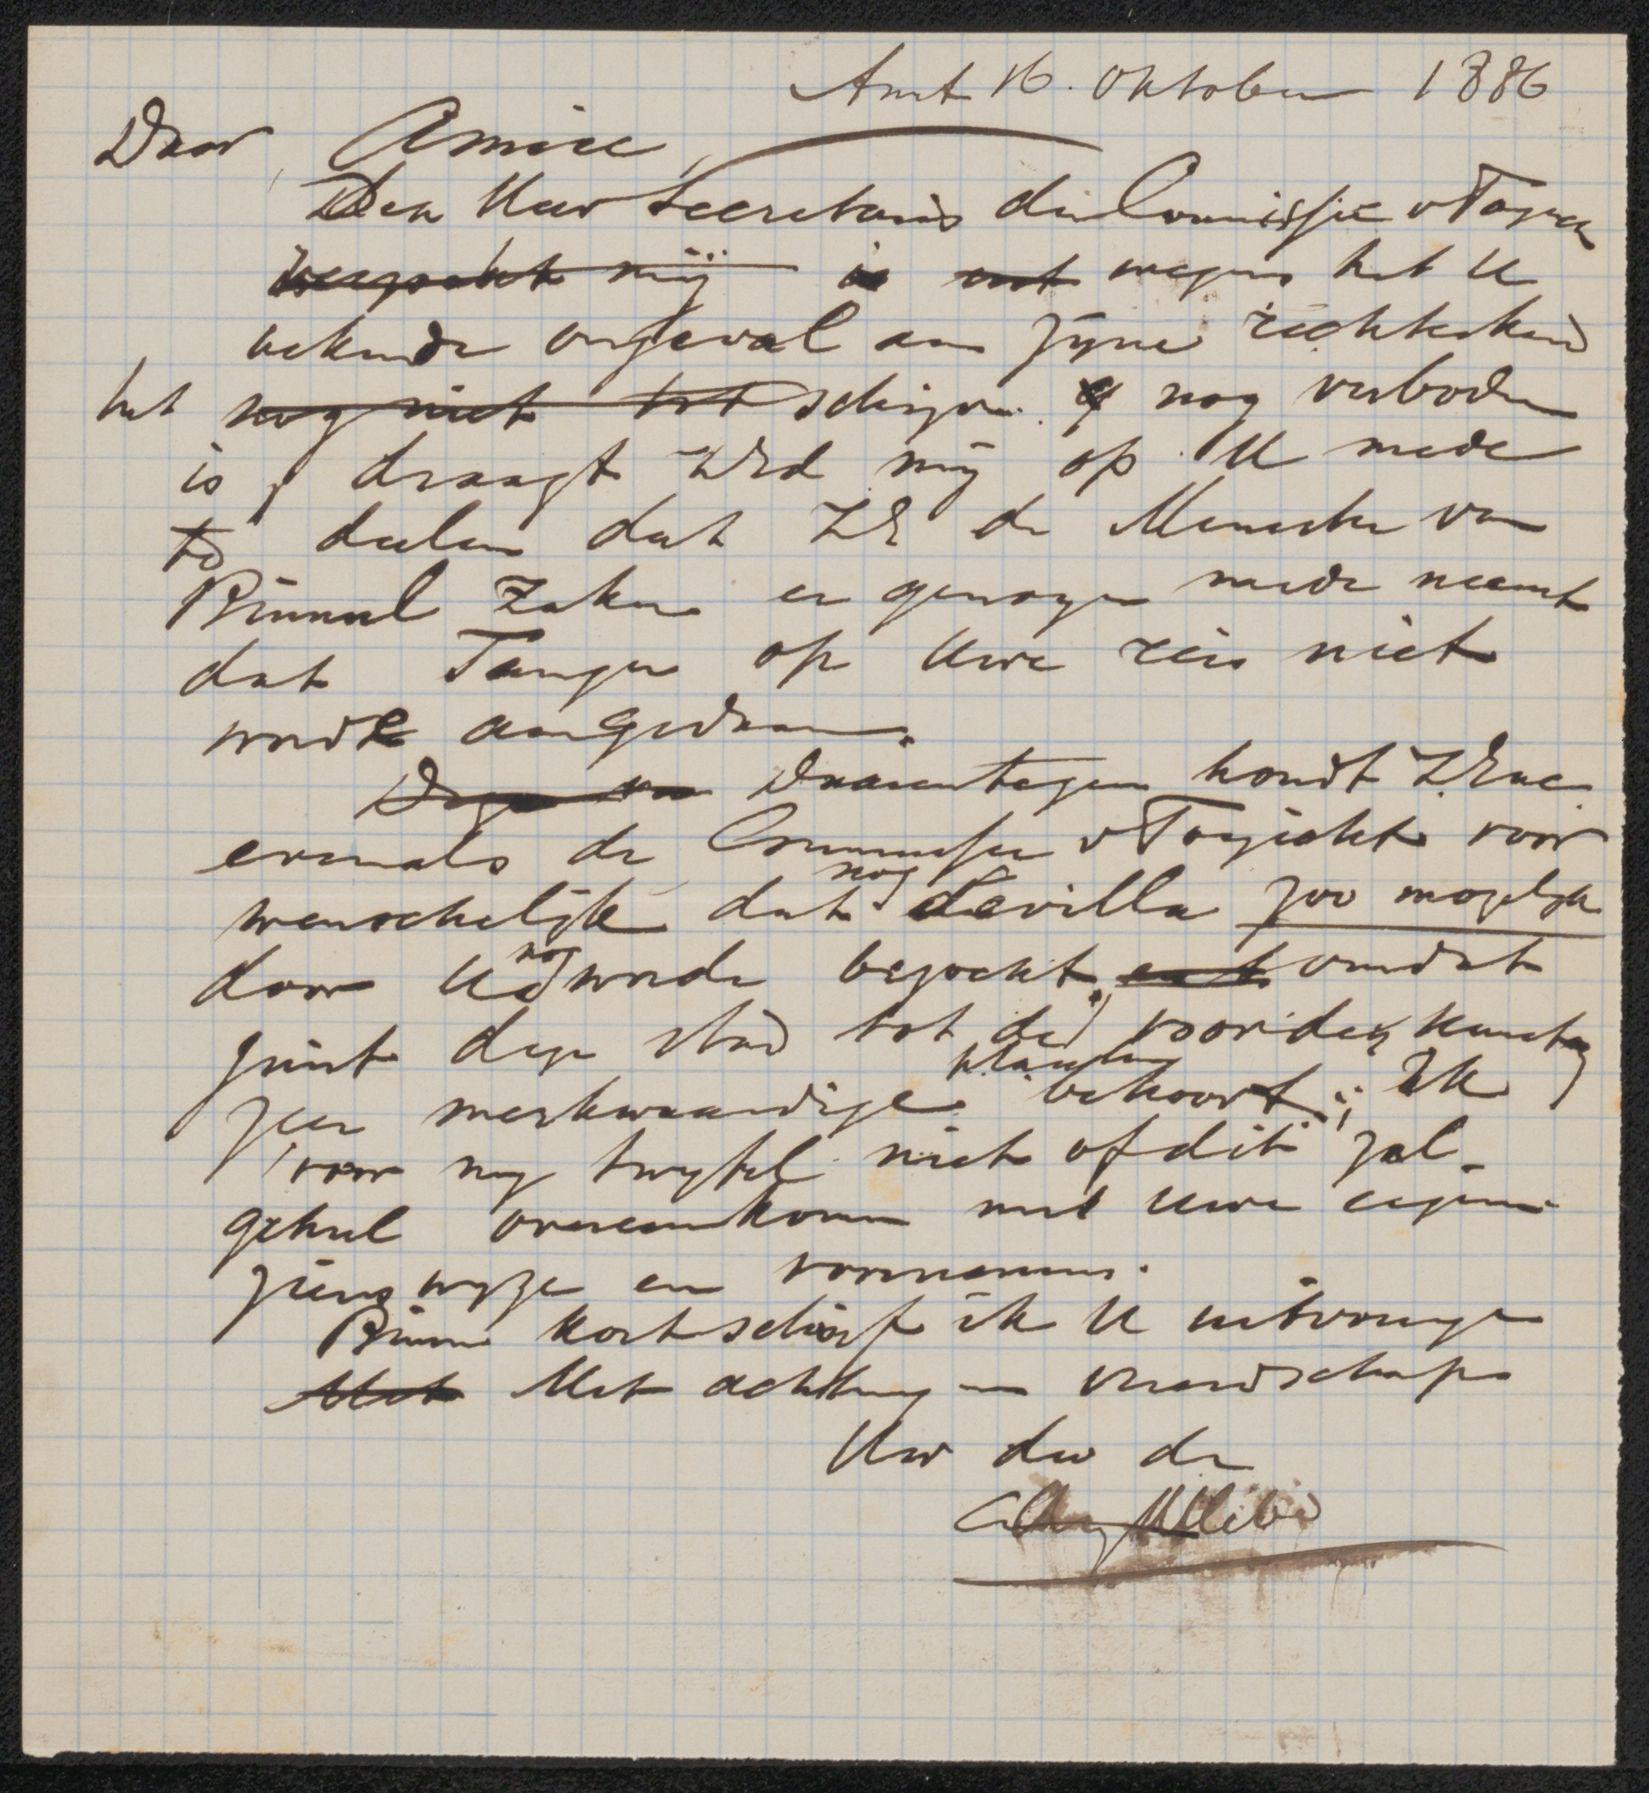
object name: letter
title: Brief aan anoniem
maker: august allebé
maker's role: draughtsman, print maker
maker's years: 1838-1927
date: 1886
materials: ink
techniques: pen, writing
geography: amsterdam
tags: travelling; tourism, sevilla